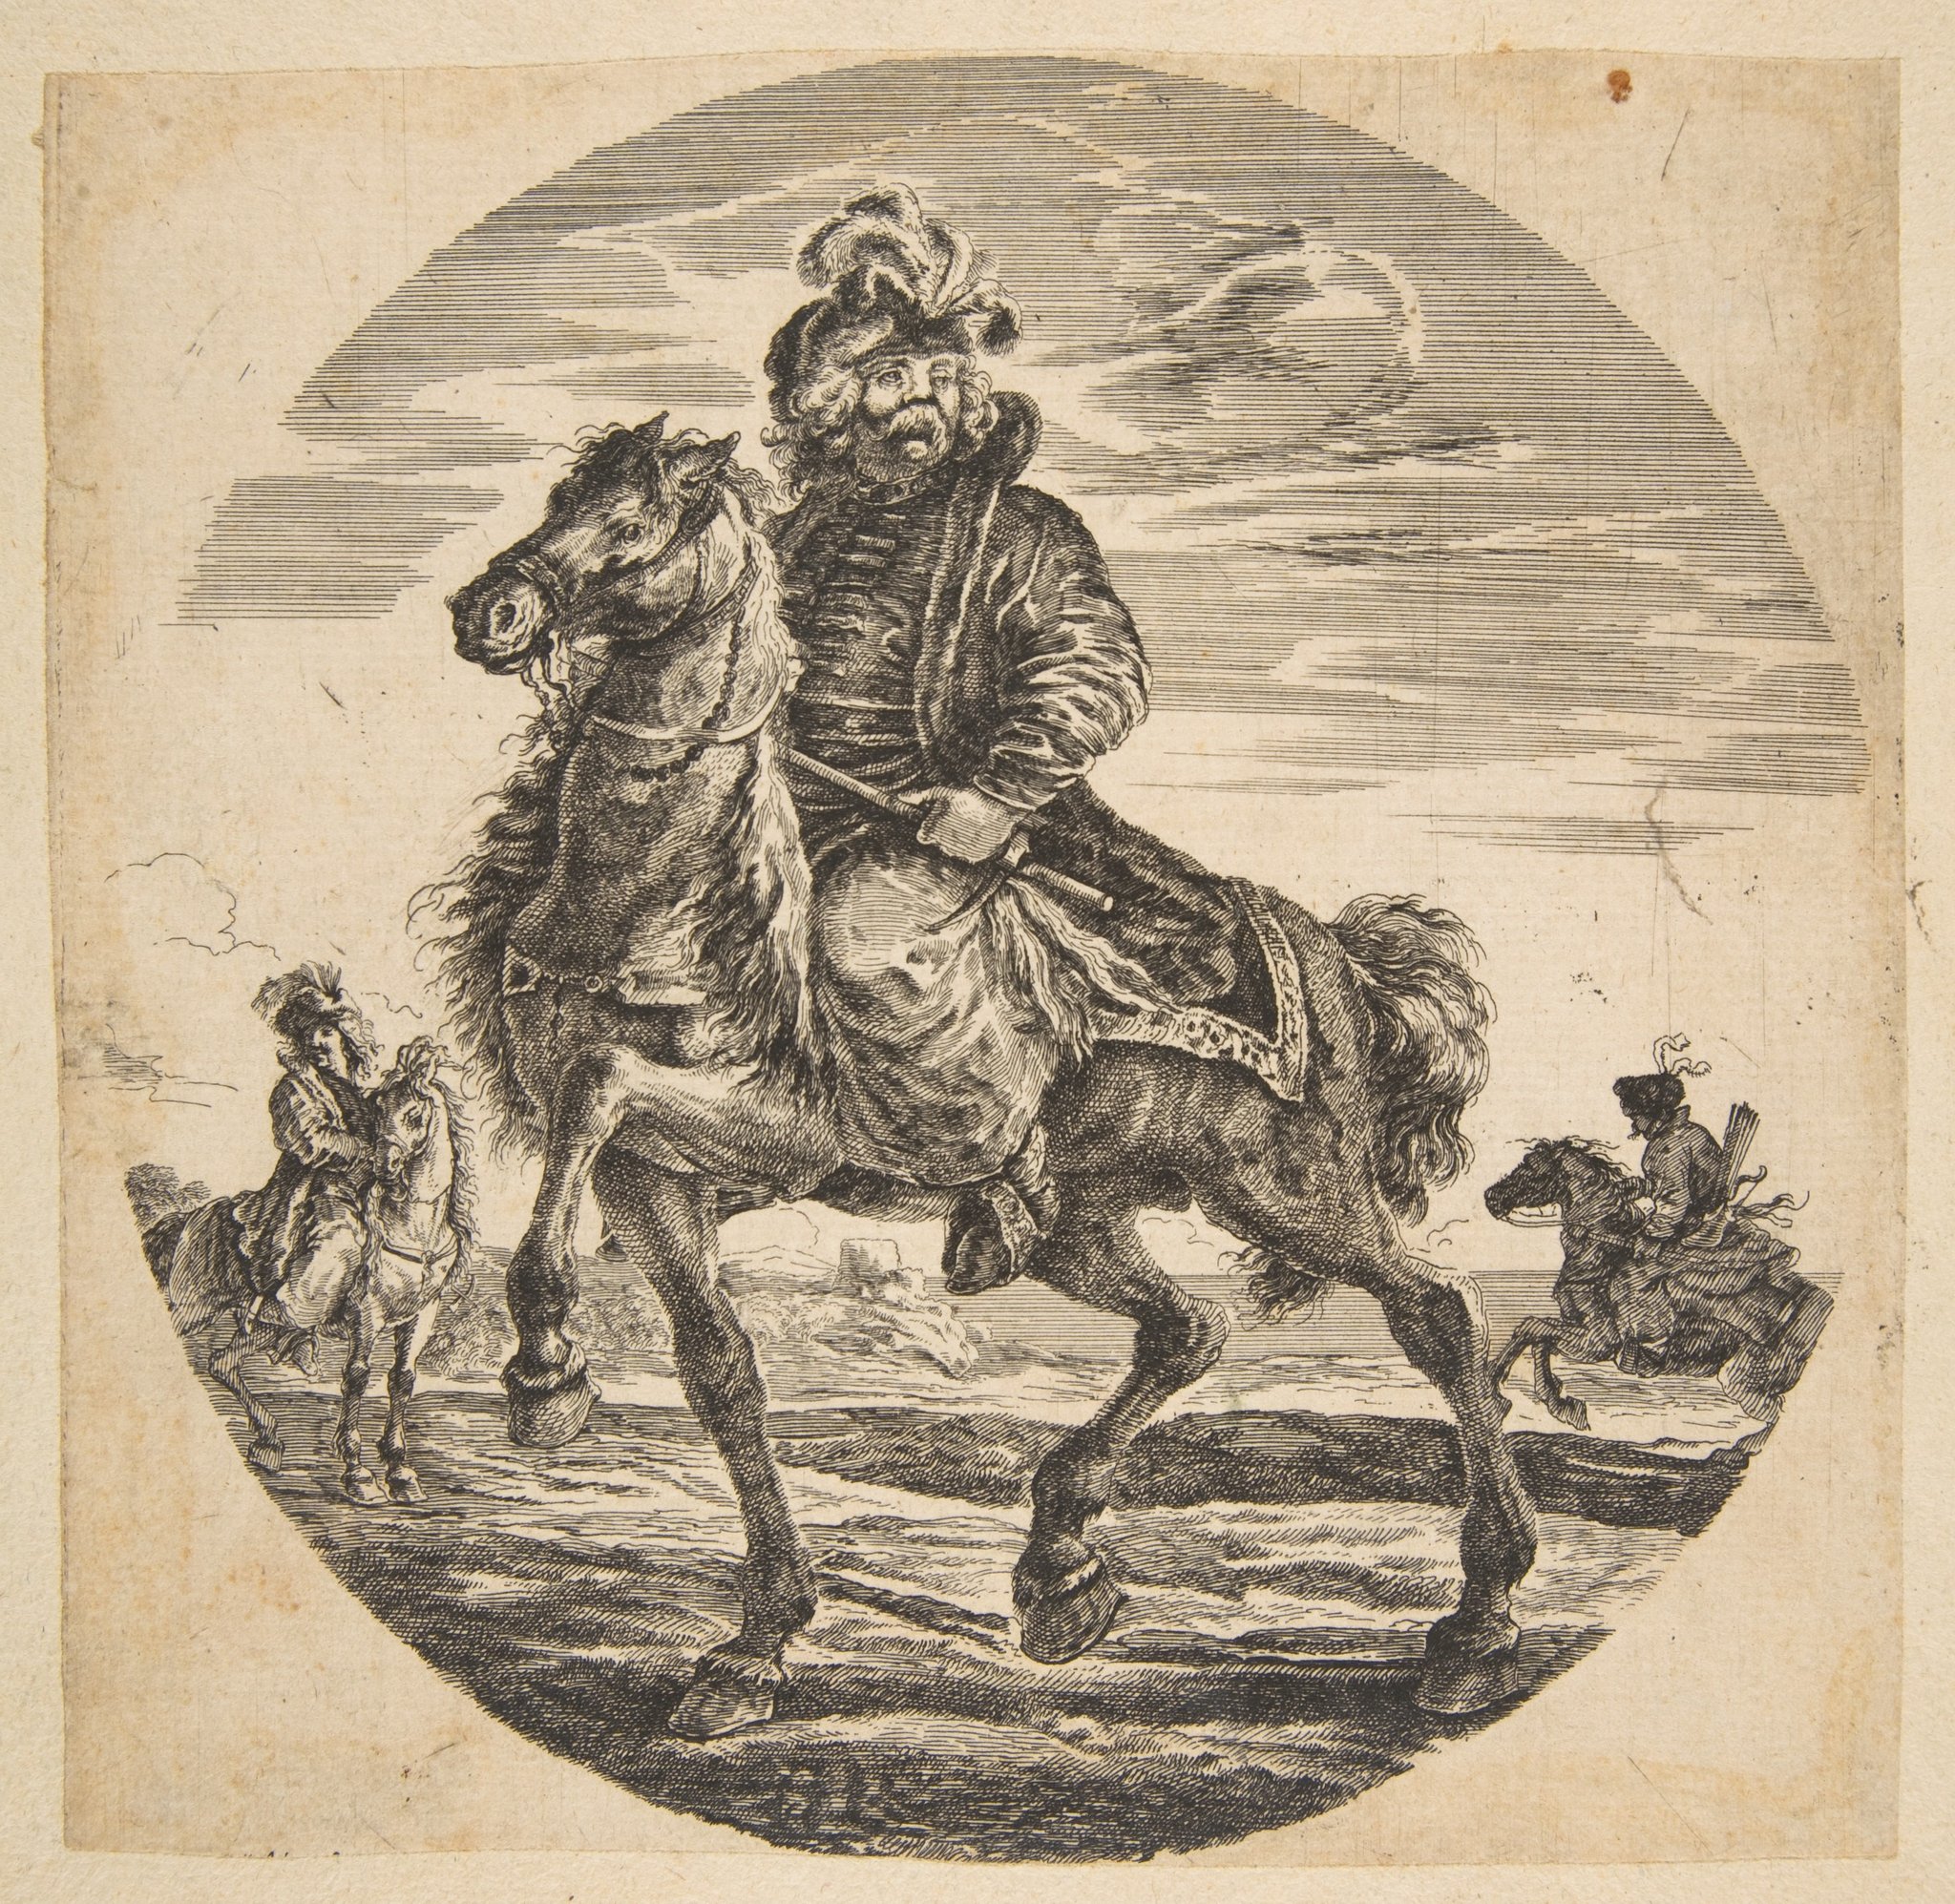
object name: print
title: Hungarian horseman riding towards the left, other horsemen in the background, a circular composition from 'Figures on Horseback' (Cavaliers nègres, polonais et hongrois)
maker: stefano della bella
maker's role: artist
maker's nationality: italian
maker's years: 1610-1664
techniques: etching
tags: men,horses